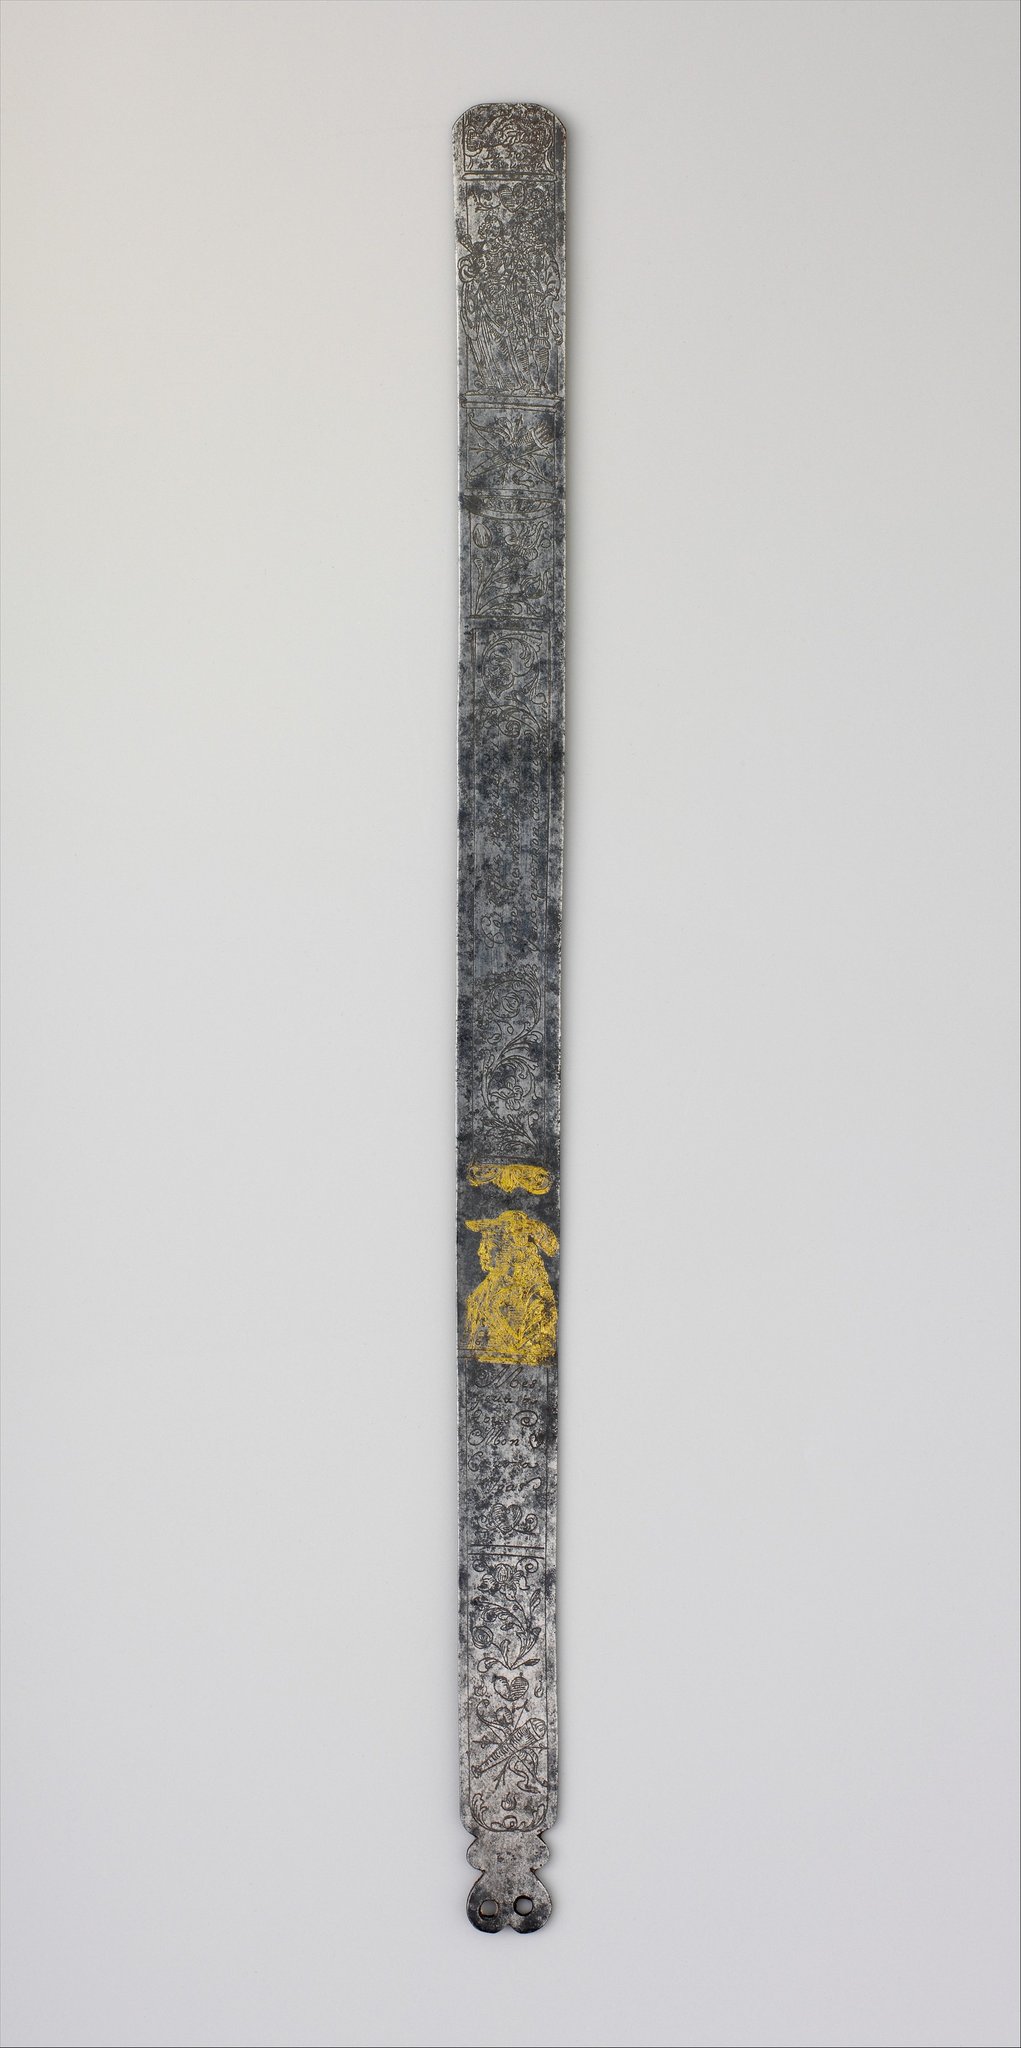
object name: busk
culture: french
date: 1601-1700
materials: metal